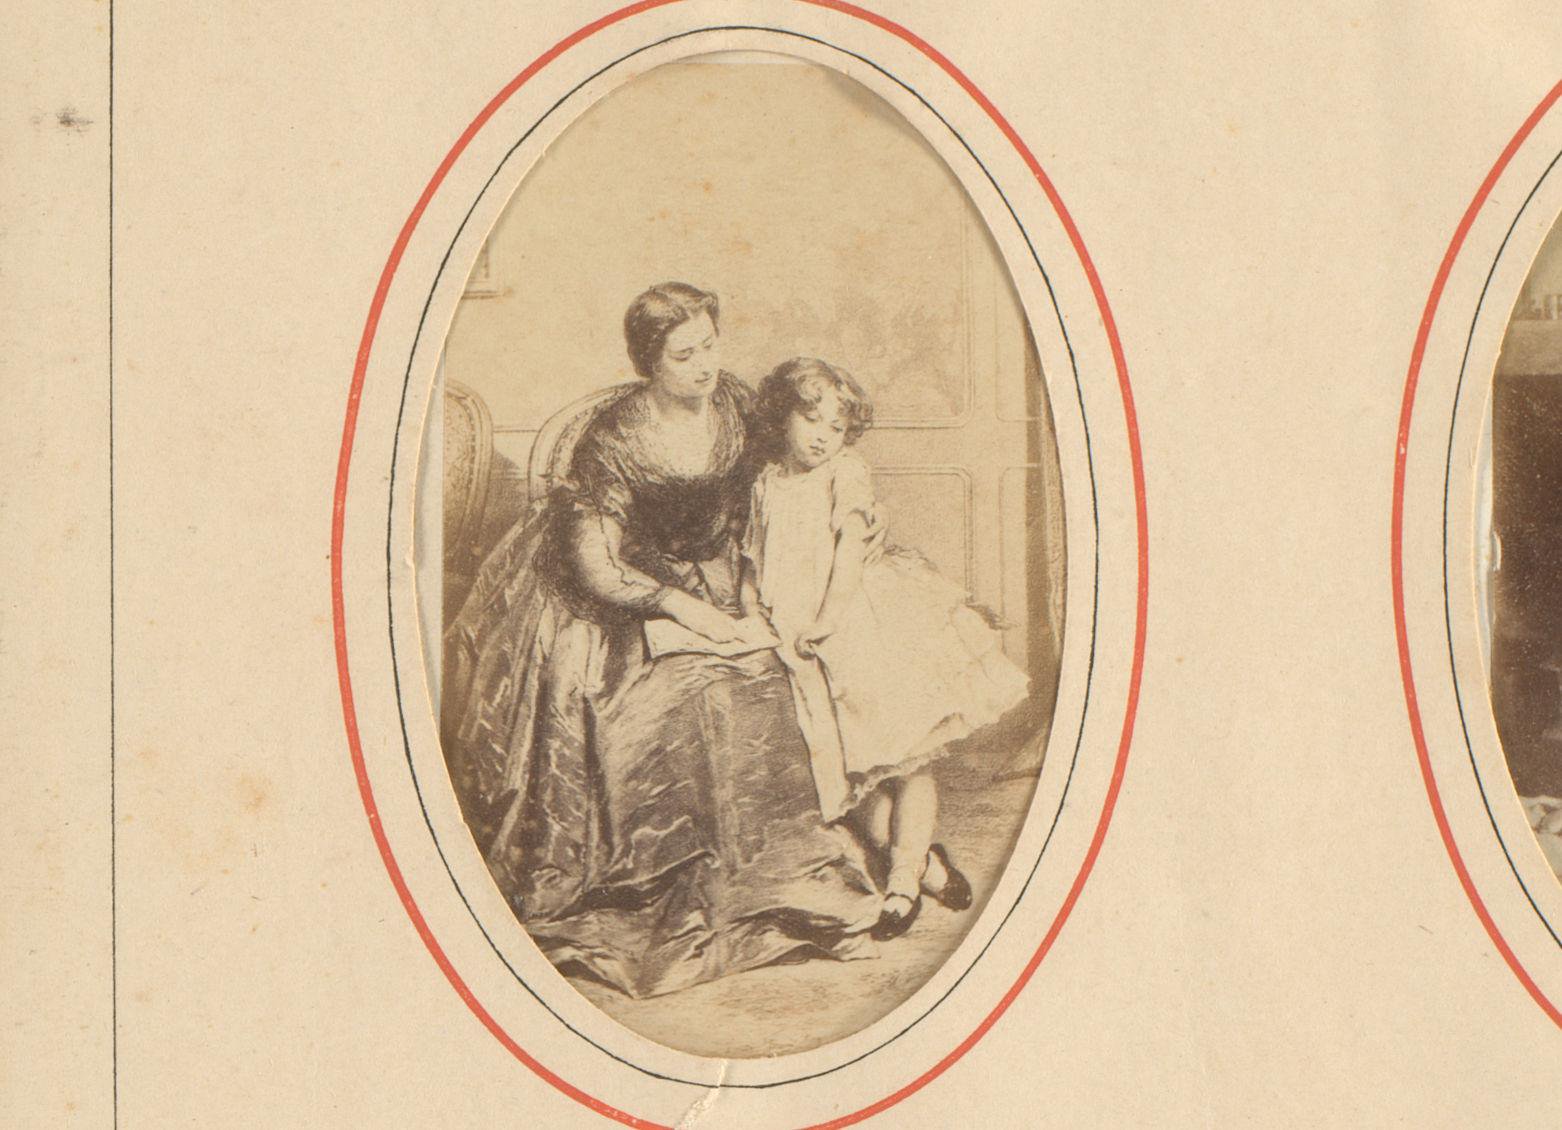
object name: reproduction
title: Fotoreproductie van een schilderij van een moeder met kind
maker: Anonymous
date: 1870-1890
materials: cardboard, paper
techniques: albumen print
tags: mother and baby or young child, education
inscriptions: inscription: ‘Souvenir/ d'Anna/ Sch[...]mann’, number: ‘359.’